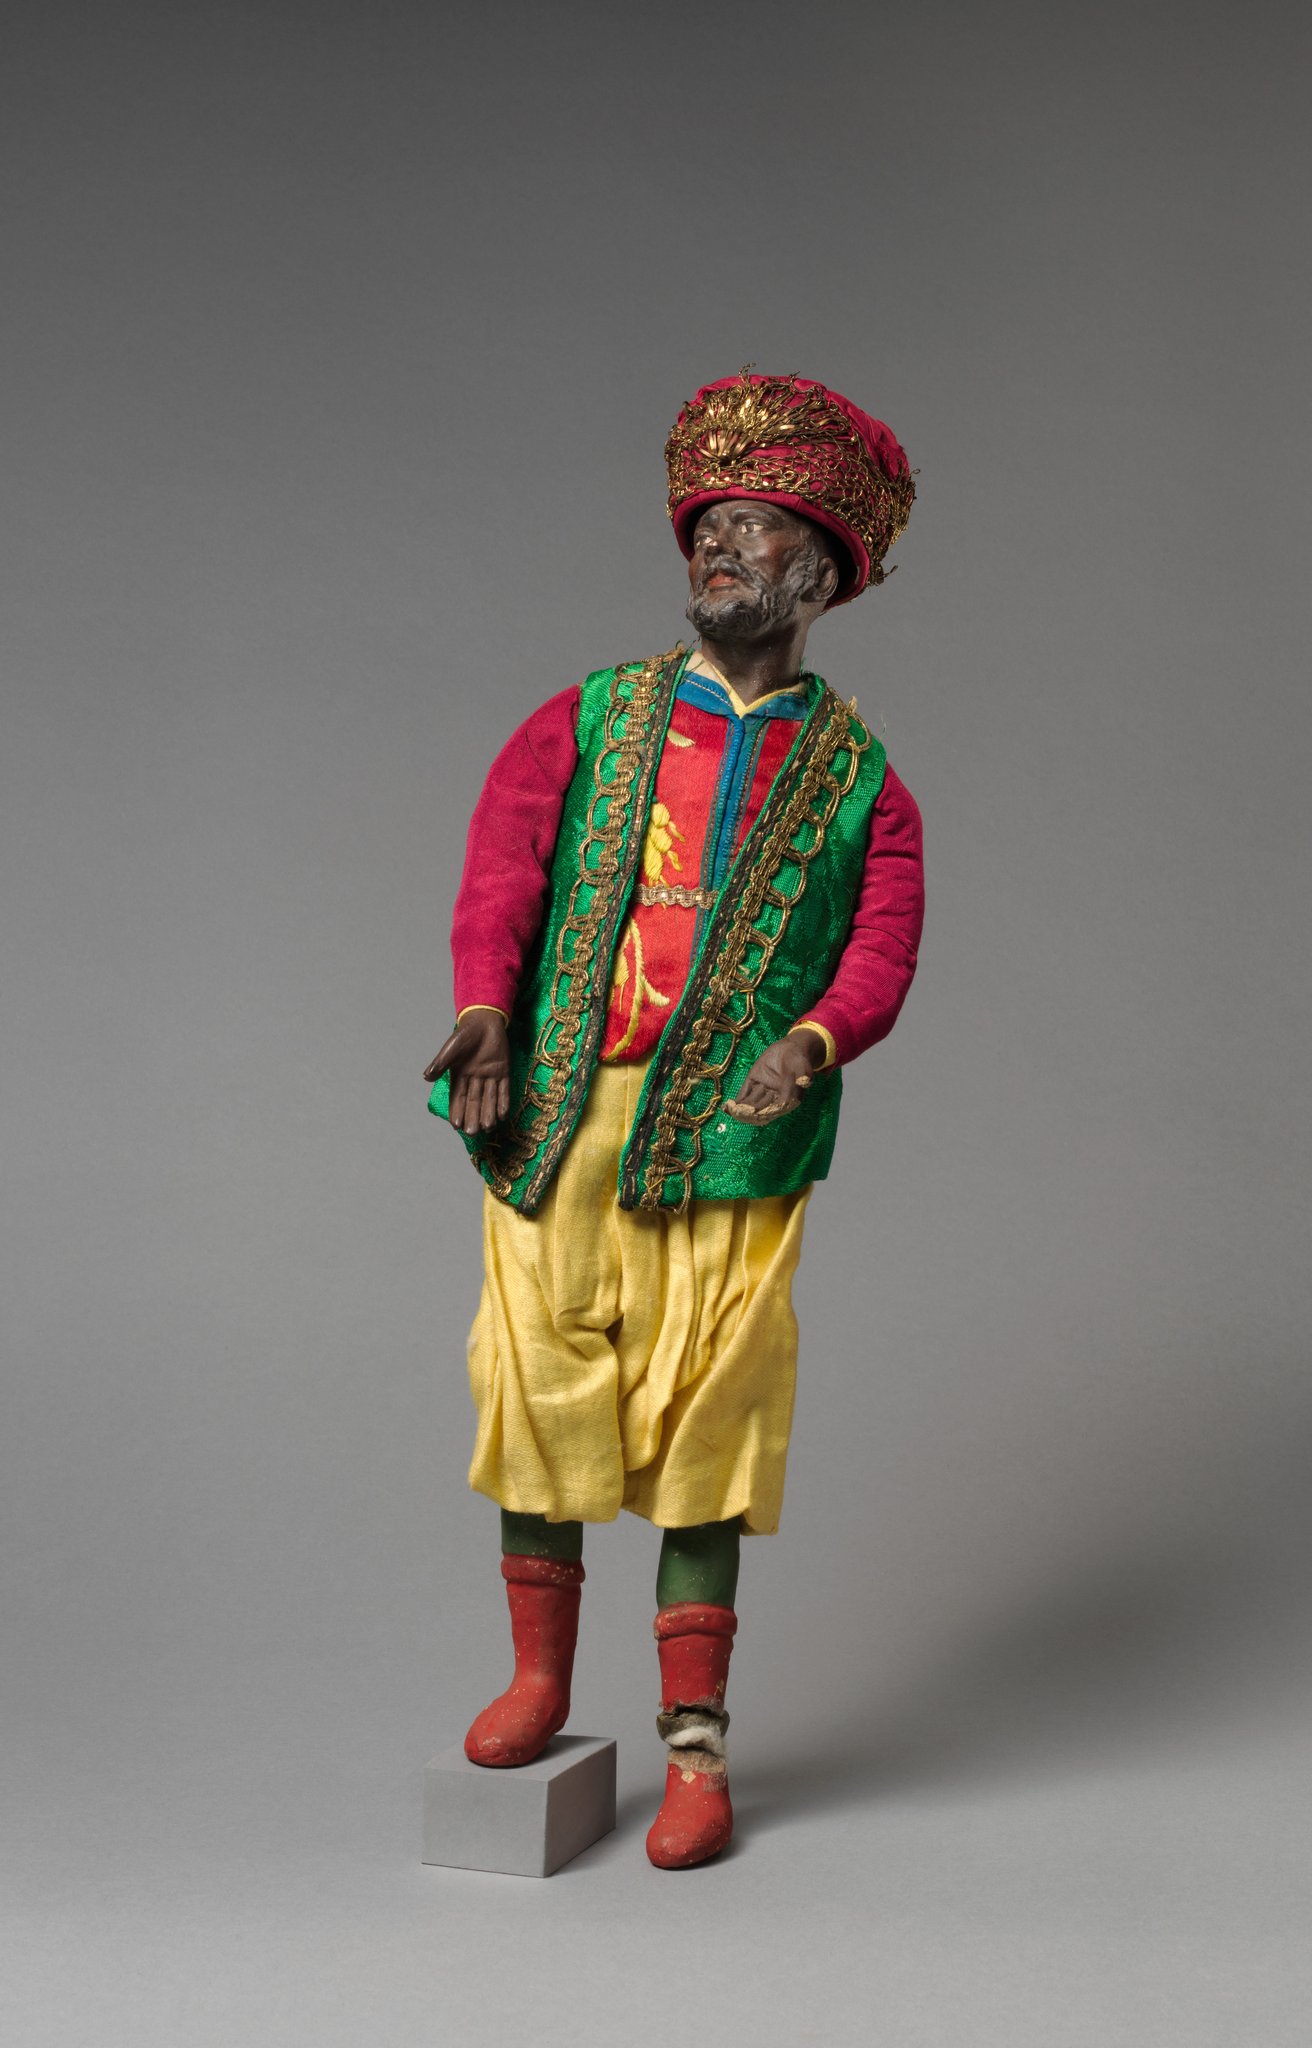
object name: crèche figure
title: King with turban crown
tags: kings